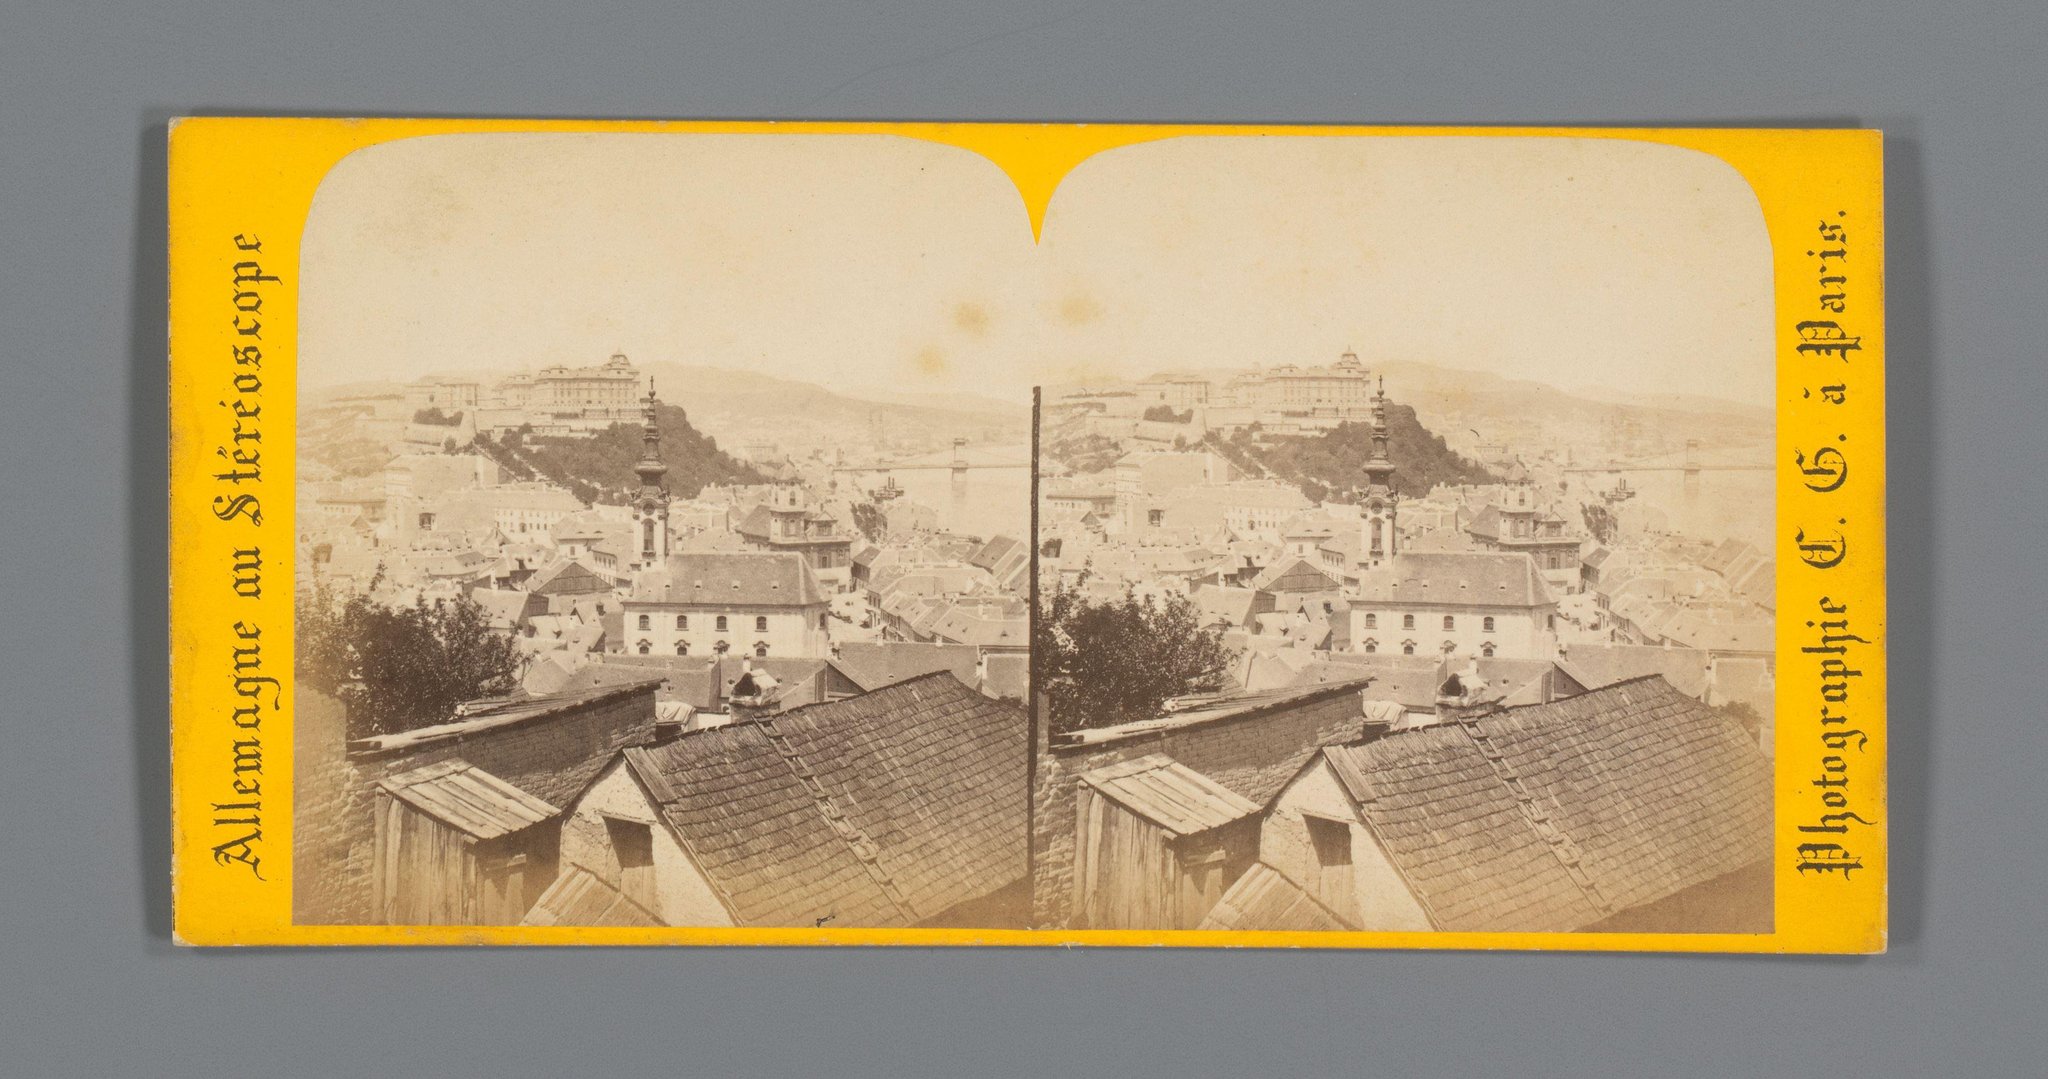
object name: stereograph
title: Bude, vue de la terrasse du tunnel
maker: charles gaudin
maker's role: publisher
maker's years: 1825-1905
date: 1868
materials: cardboard, paper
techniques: albumen print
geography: budapest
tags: city-view in general; 'veduta'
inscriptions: number: ‘136.’